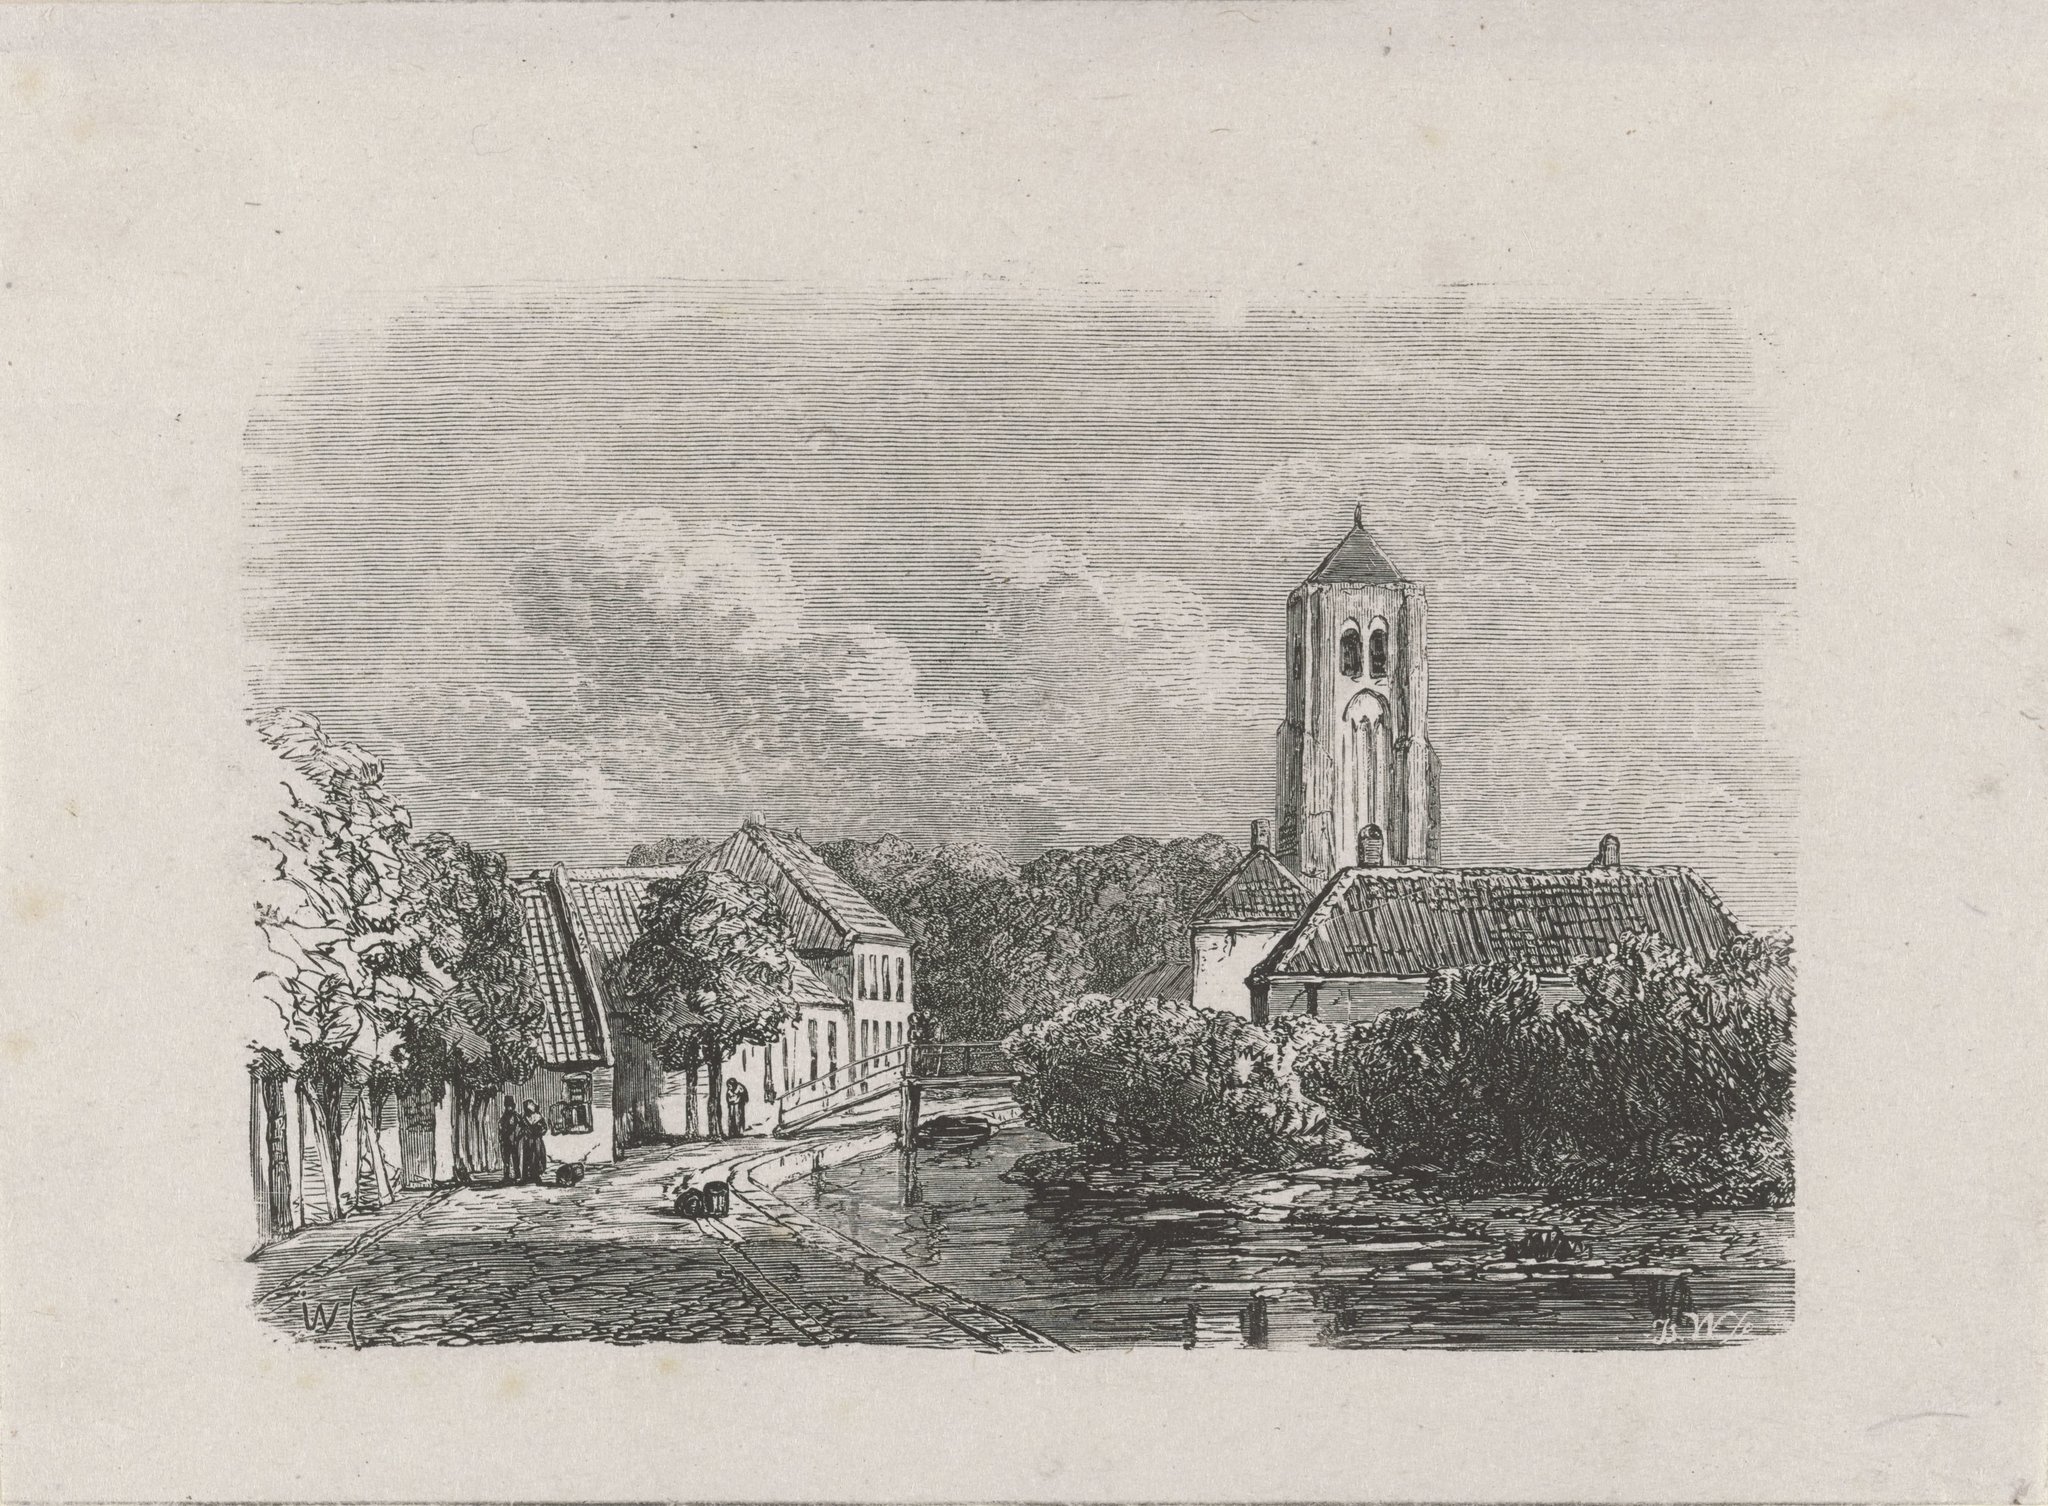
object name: print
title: Gracht in een stad met een kerktoren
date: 1836-1912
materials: paper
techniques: engraving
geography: netherlands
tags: canal, street, tower (of house or building)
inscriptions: collector's mark: Lugt 2228